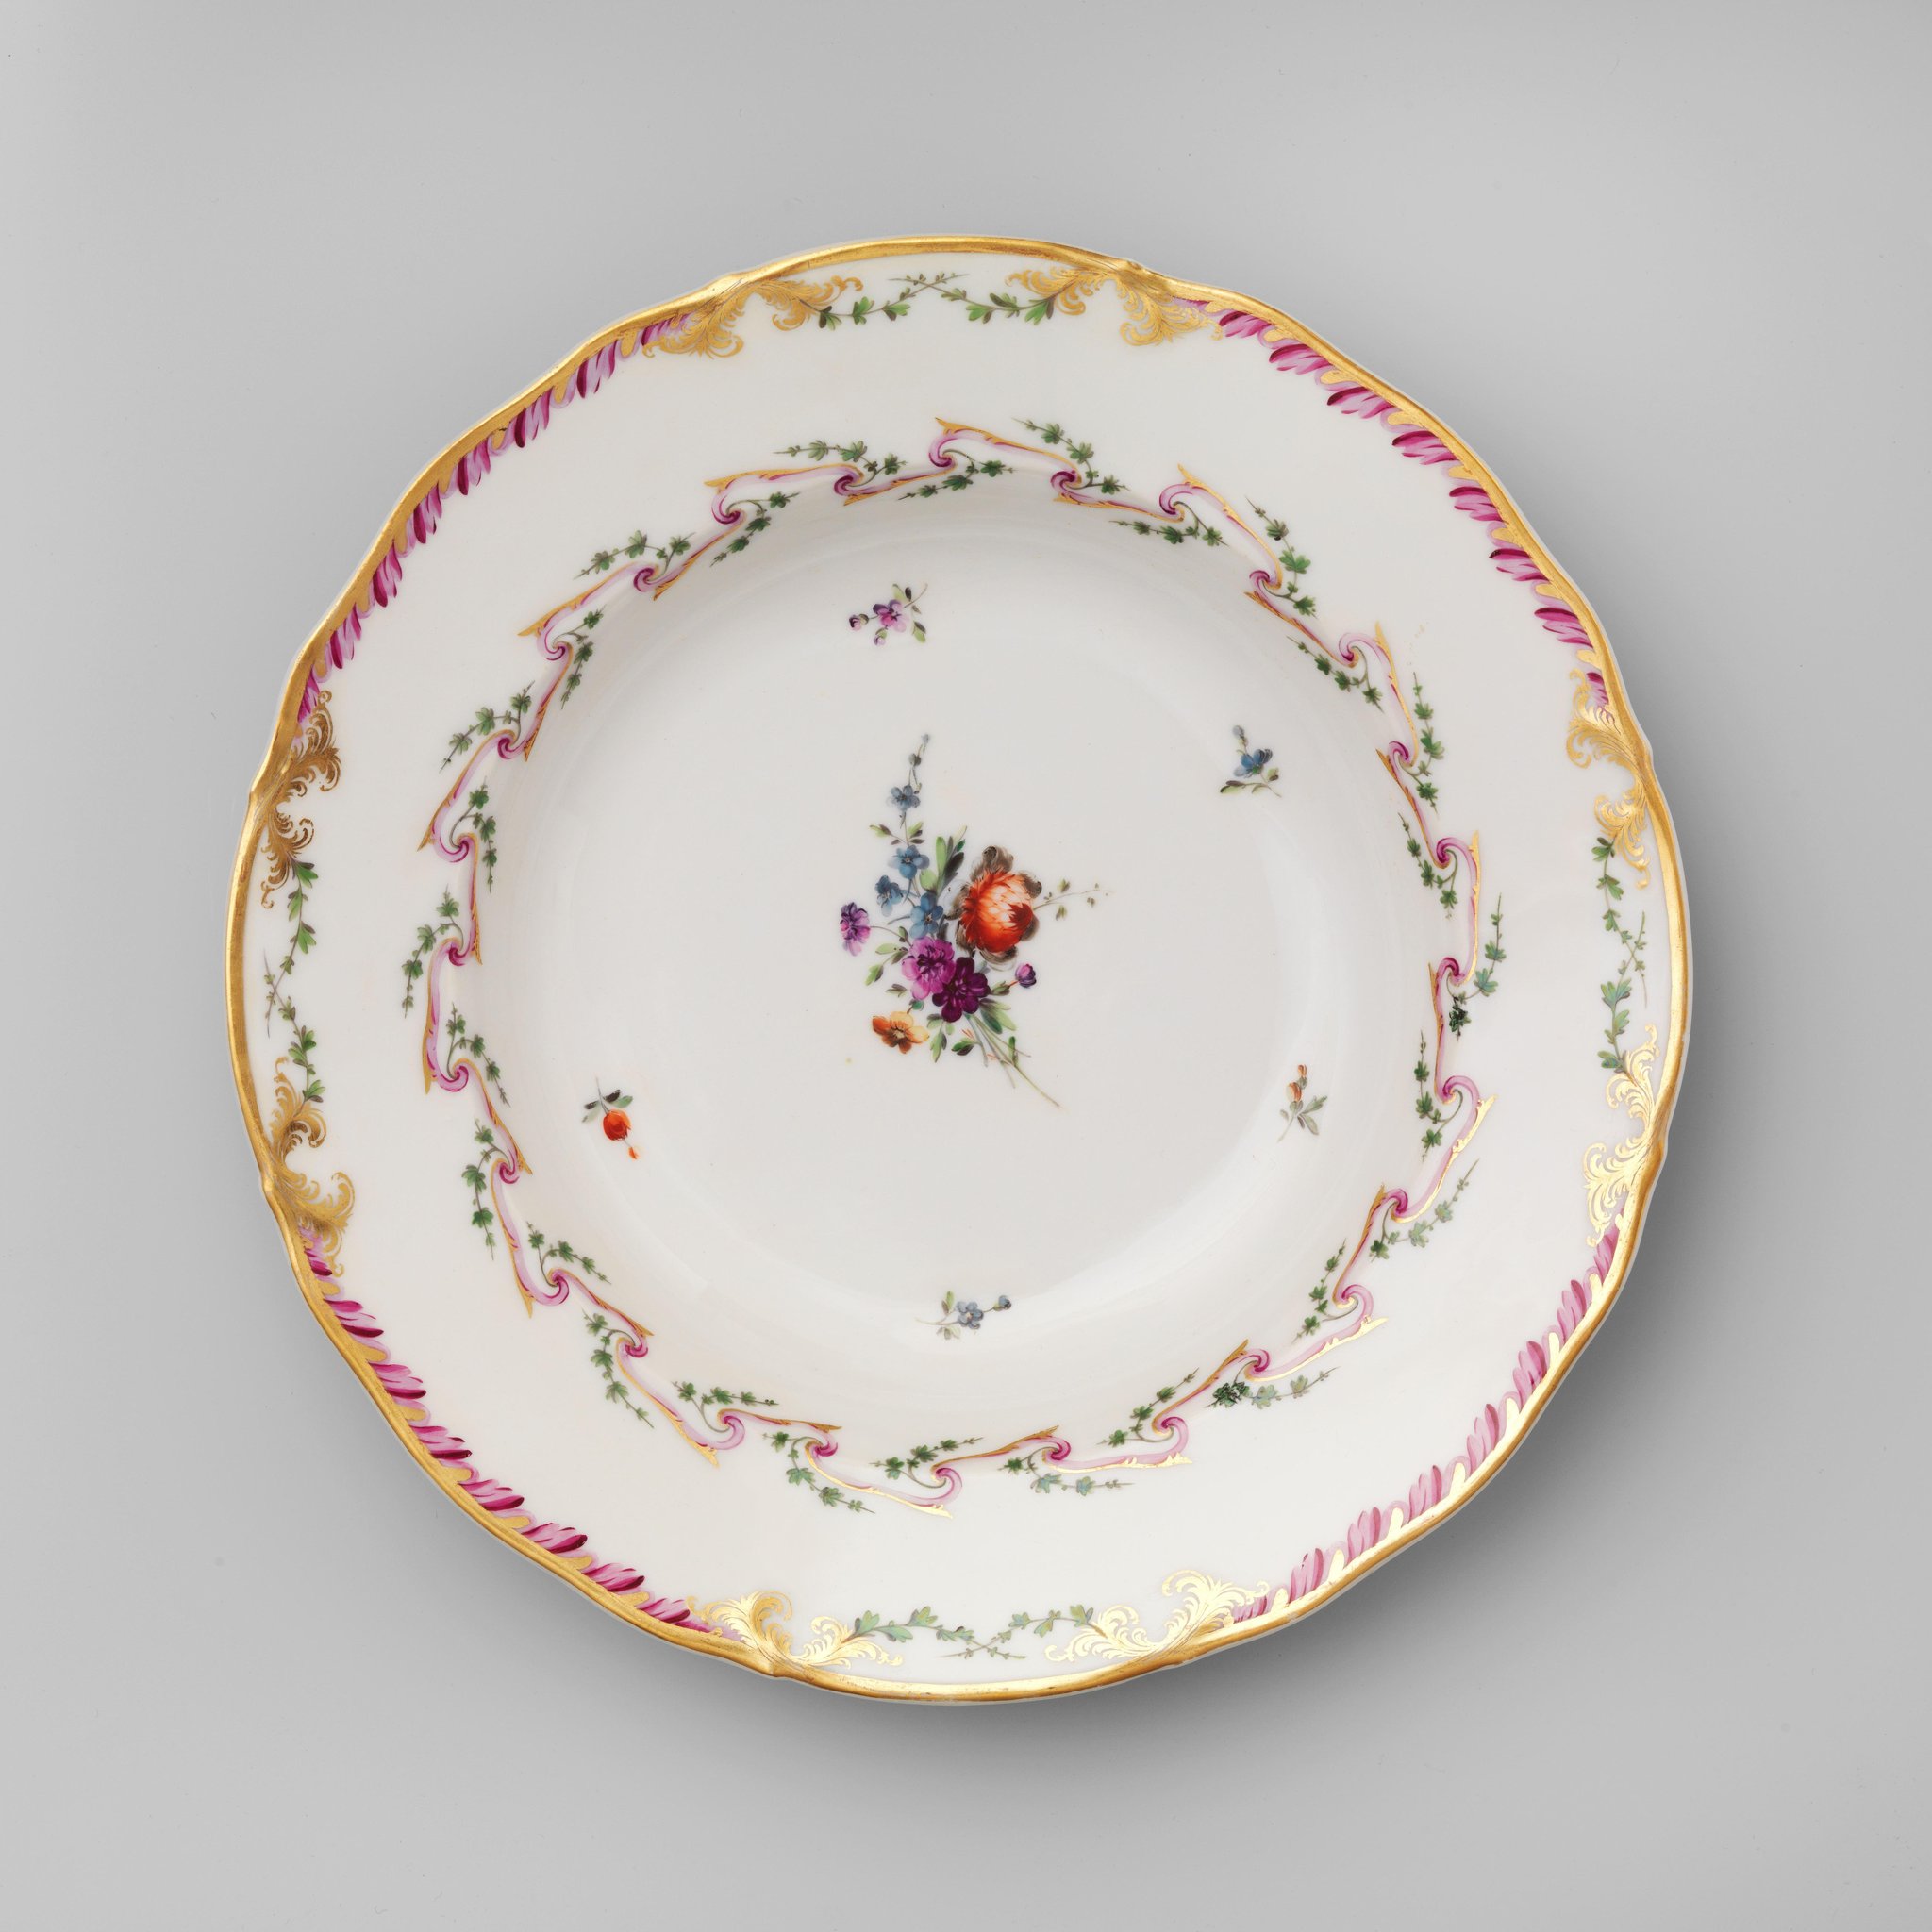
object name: plate dish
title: Bord, diep model, behorend bij een servies met geslingerd lintmotief met bladertakken, bloemboeketten en gestrooide bloemtakken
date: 1780-1820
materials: porcelain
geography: amsterdam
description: Bord, diep model, behorend bij een servies van porselein met geslingerd lintmotief in paars en goud met groene bladertakken, bloemboeketten en gestrooide bloemtakken. Randen lichtgegolfd met decoratie in goud met paars bladmotief waartussen groen gekruist bladmotief. Gemerkt: Mf. DE DIHL ET GUERHARD à PARIS. Serie van elf stuks.